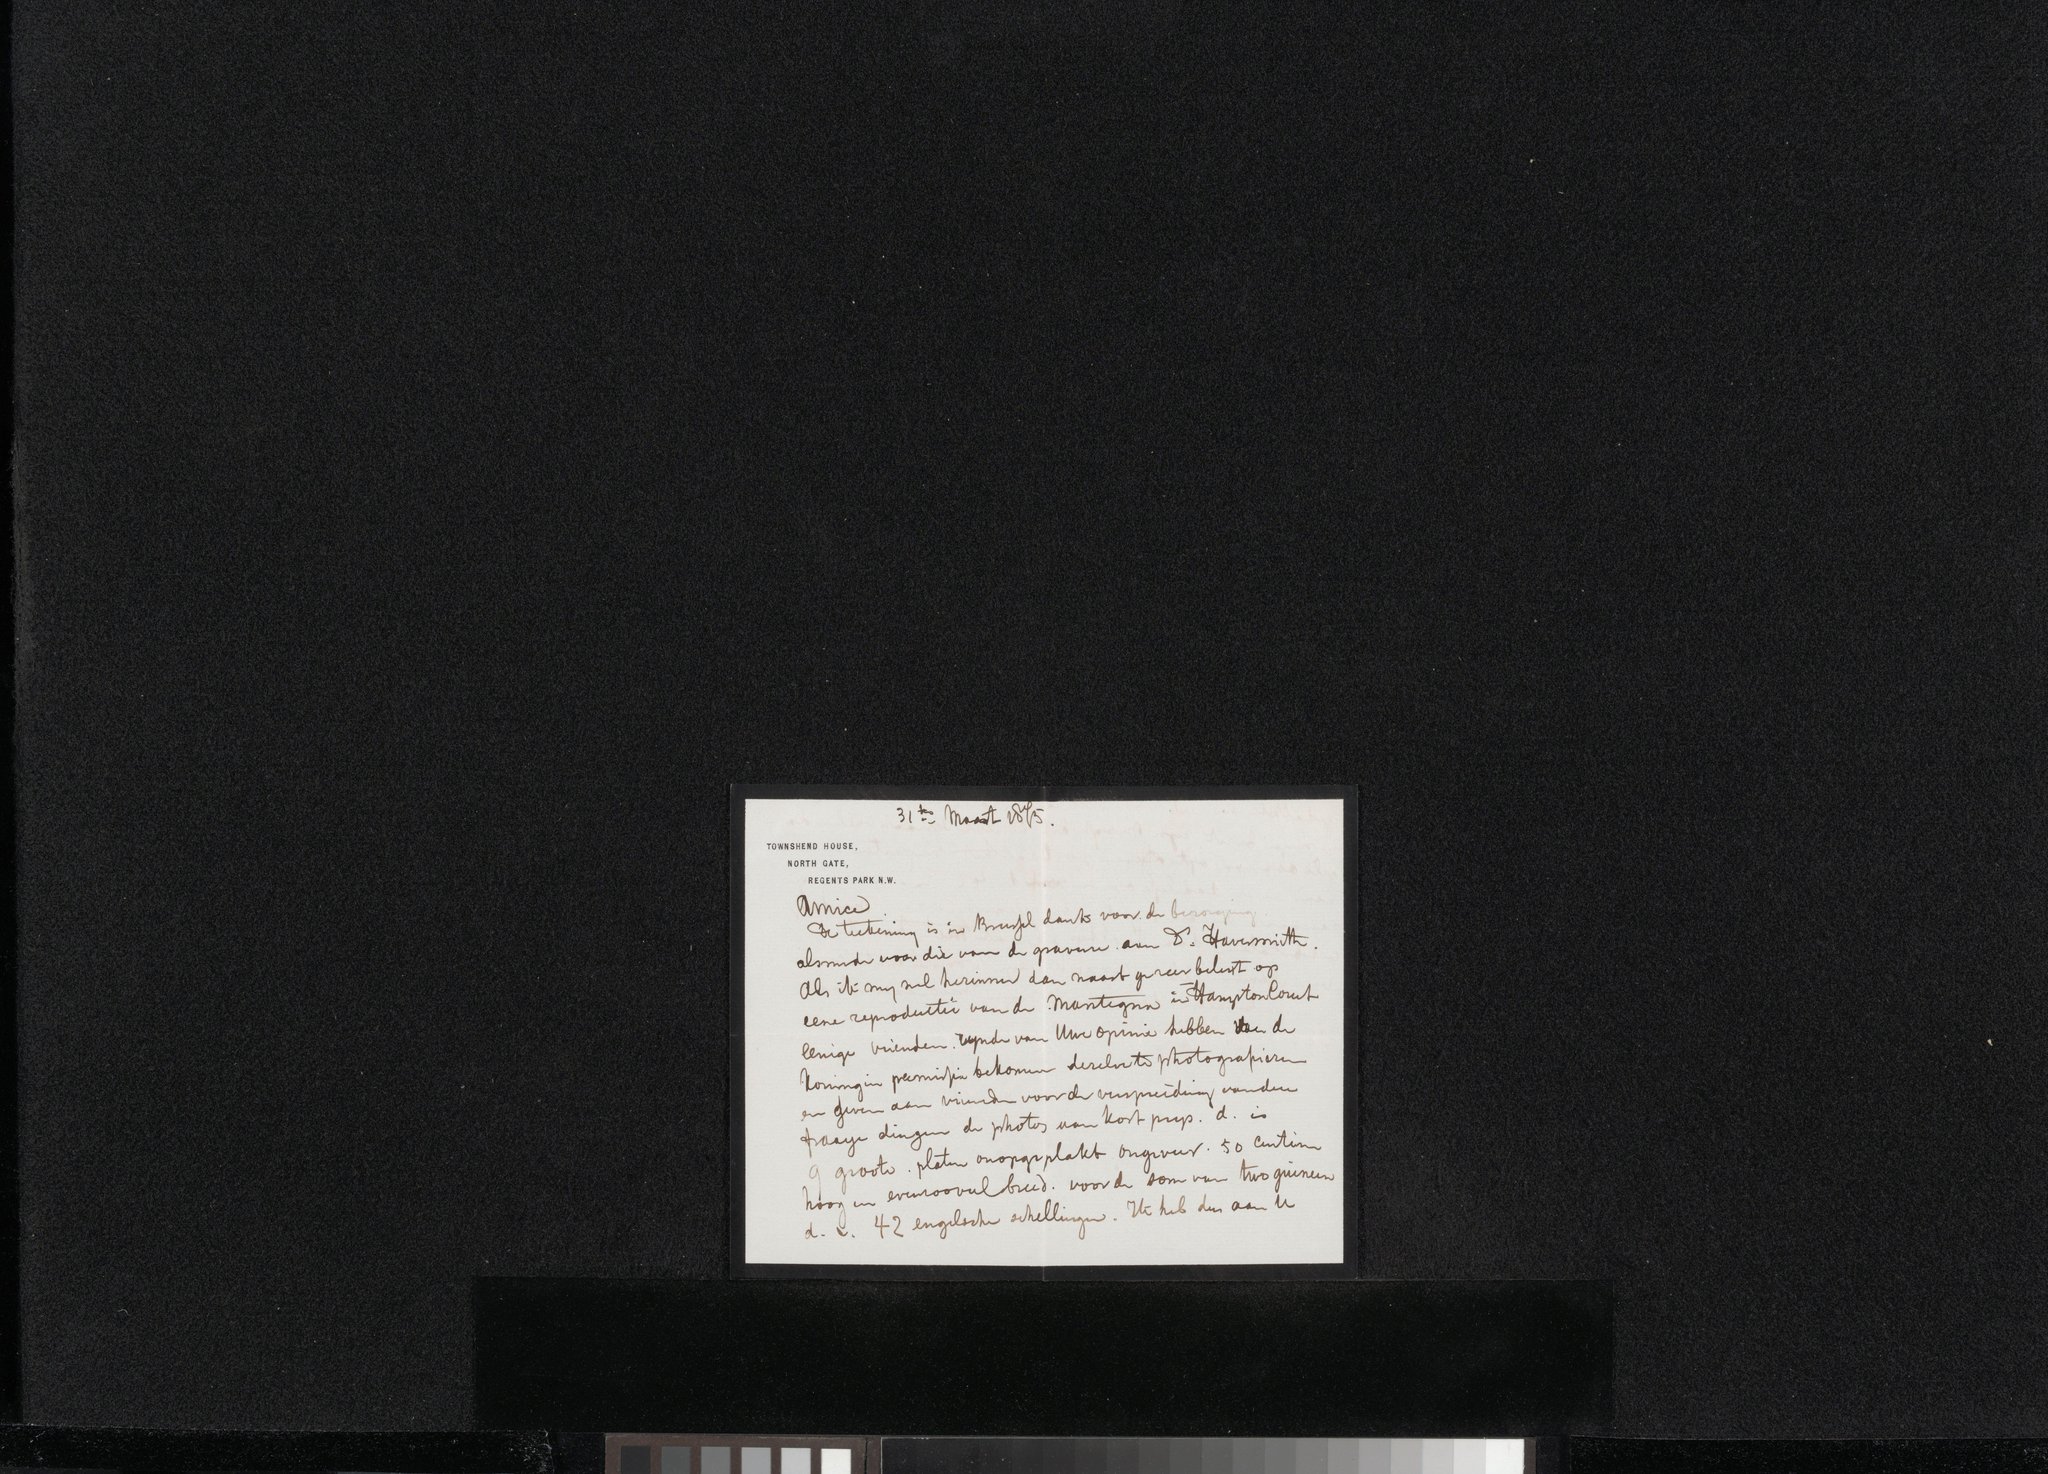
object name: letter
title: Brief aan Carel Vosmaer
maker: lourens alma tadema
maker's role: draughtsman, print maker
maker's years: 1836-1912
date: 1875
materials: ink, paper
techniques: pen, printing, writing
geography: london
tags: the hague, painter, print maker, draughtsman, hendrik willem mesdag, carel vosmaer, piet paaltjens, drawing, photography, cinematography, money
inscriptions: watermark